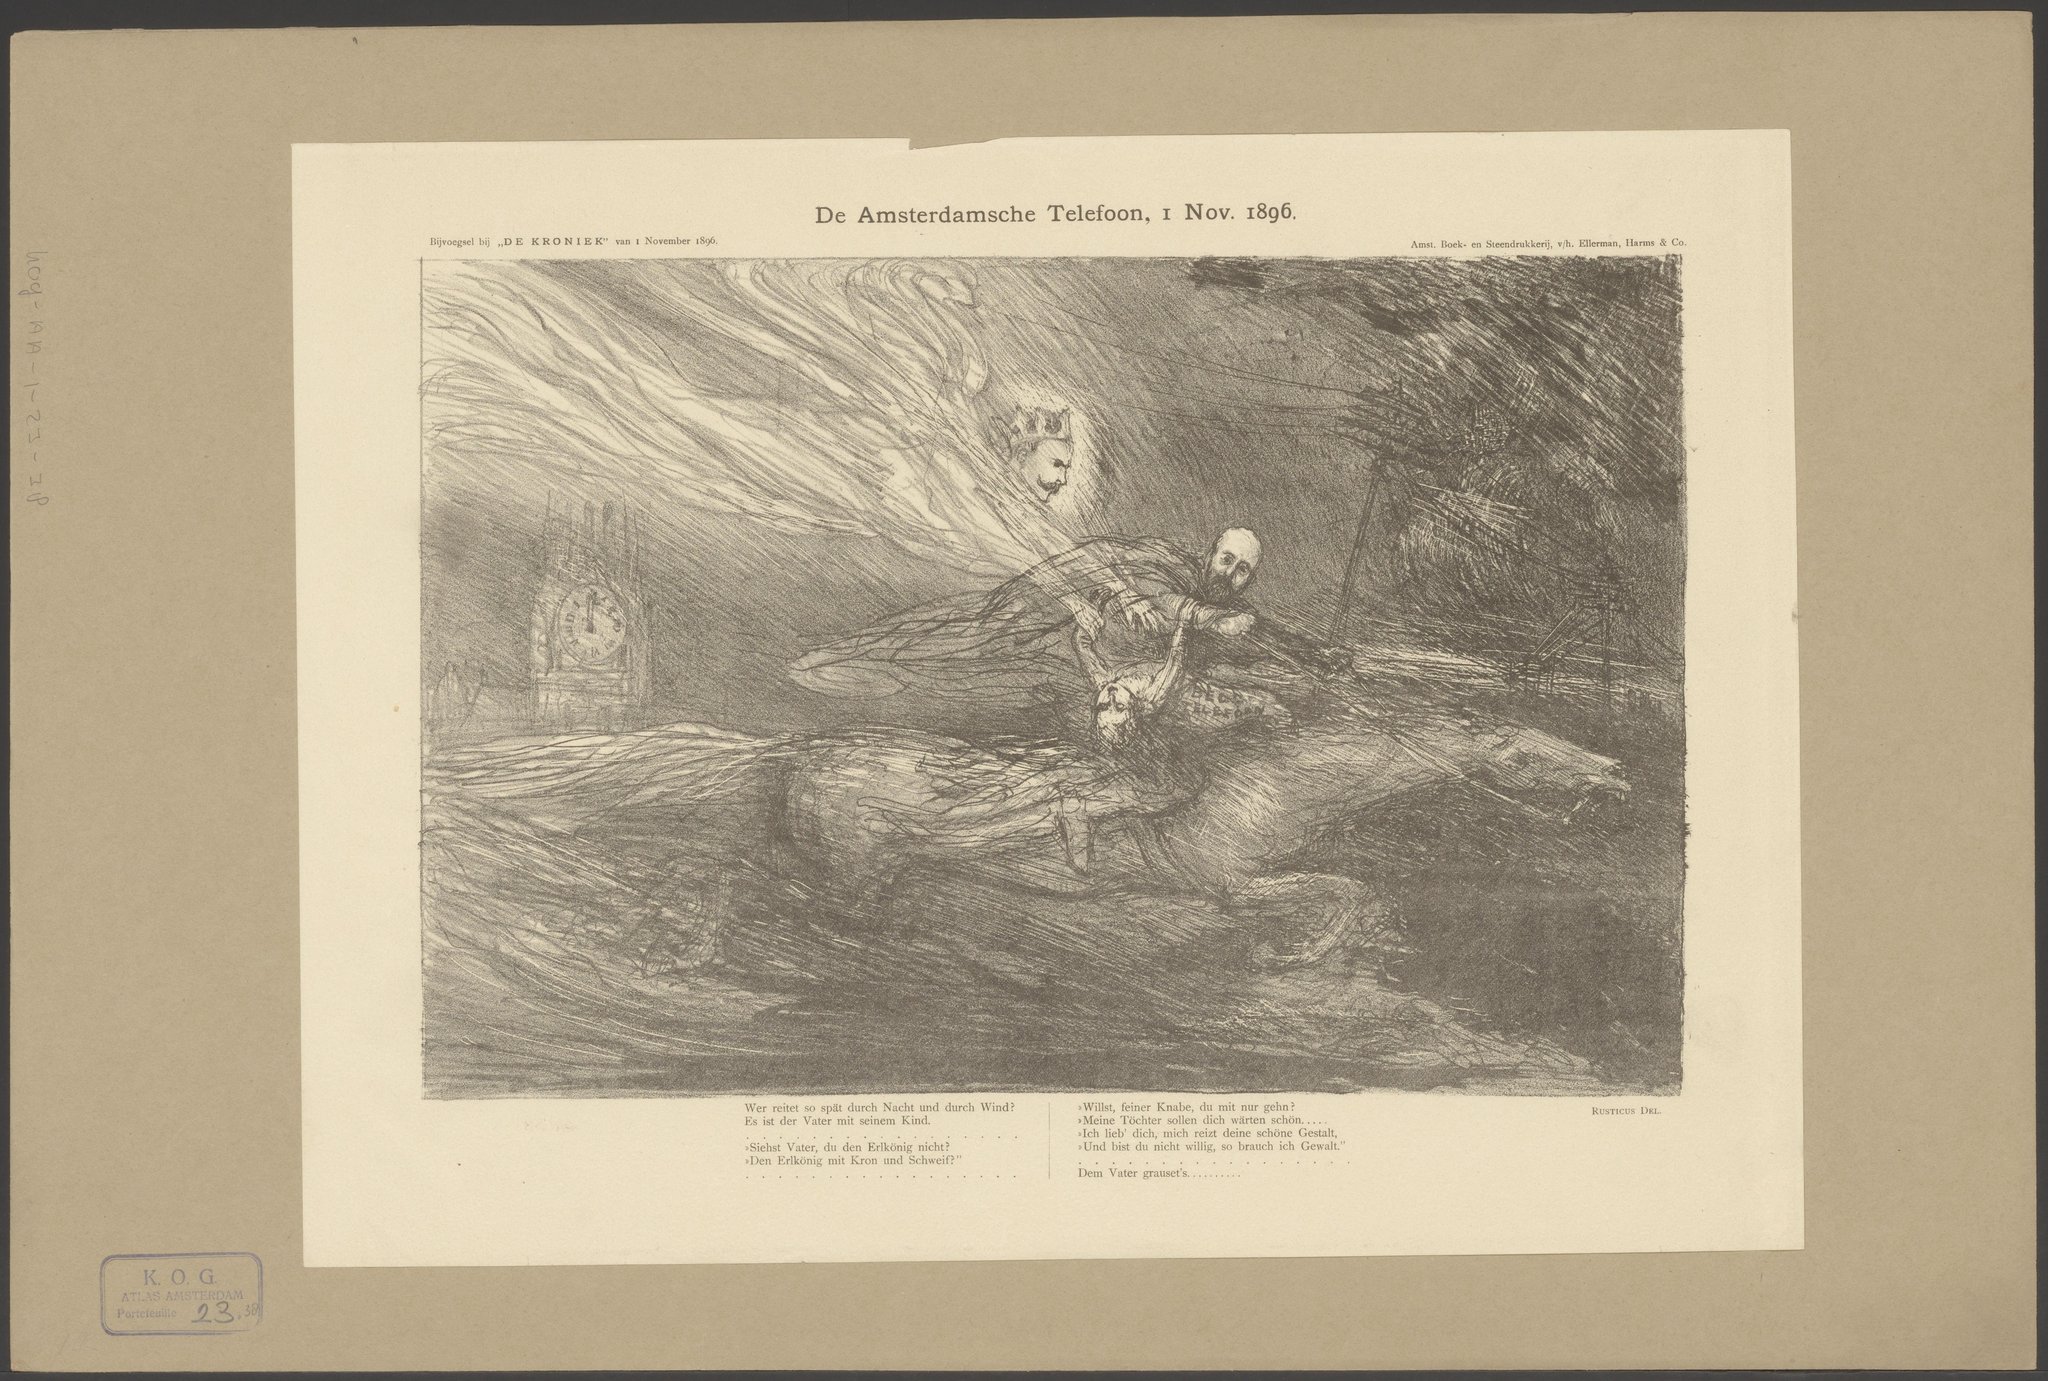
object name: cartoon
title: De Amsterdamsche Telefoon, 1 Nov. 1896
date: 1896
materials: paper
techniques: letterpress printing, lithograph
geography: amsterdam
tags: voorschoten, the hague, politician, telegraph pole, telephone pole, horse in motion, specific works of literature, political caricatures and satires, amsterdam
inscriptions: collector's mark: Lugt 1641b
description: Onderwerpsrubriek binnen de Atlas Amsterdam: Gemeentebedrijven.